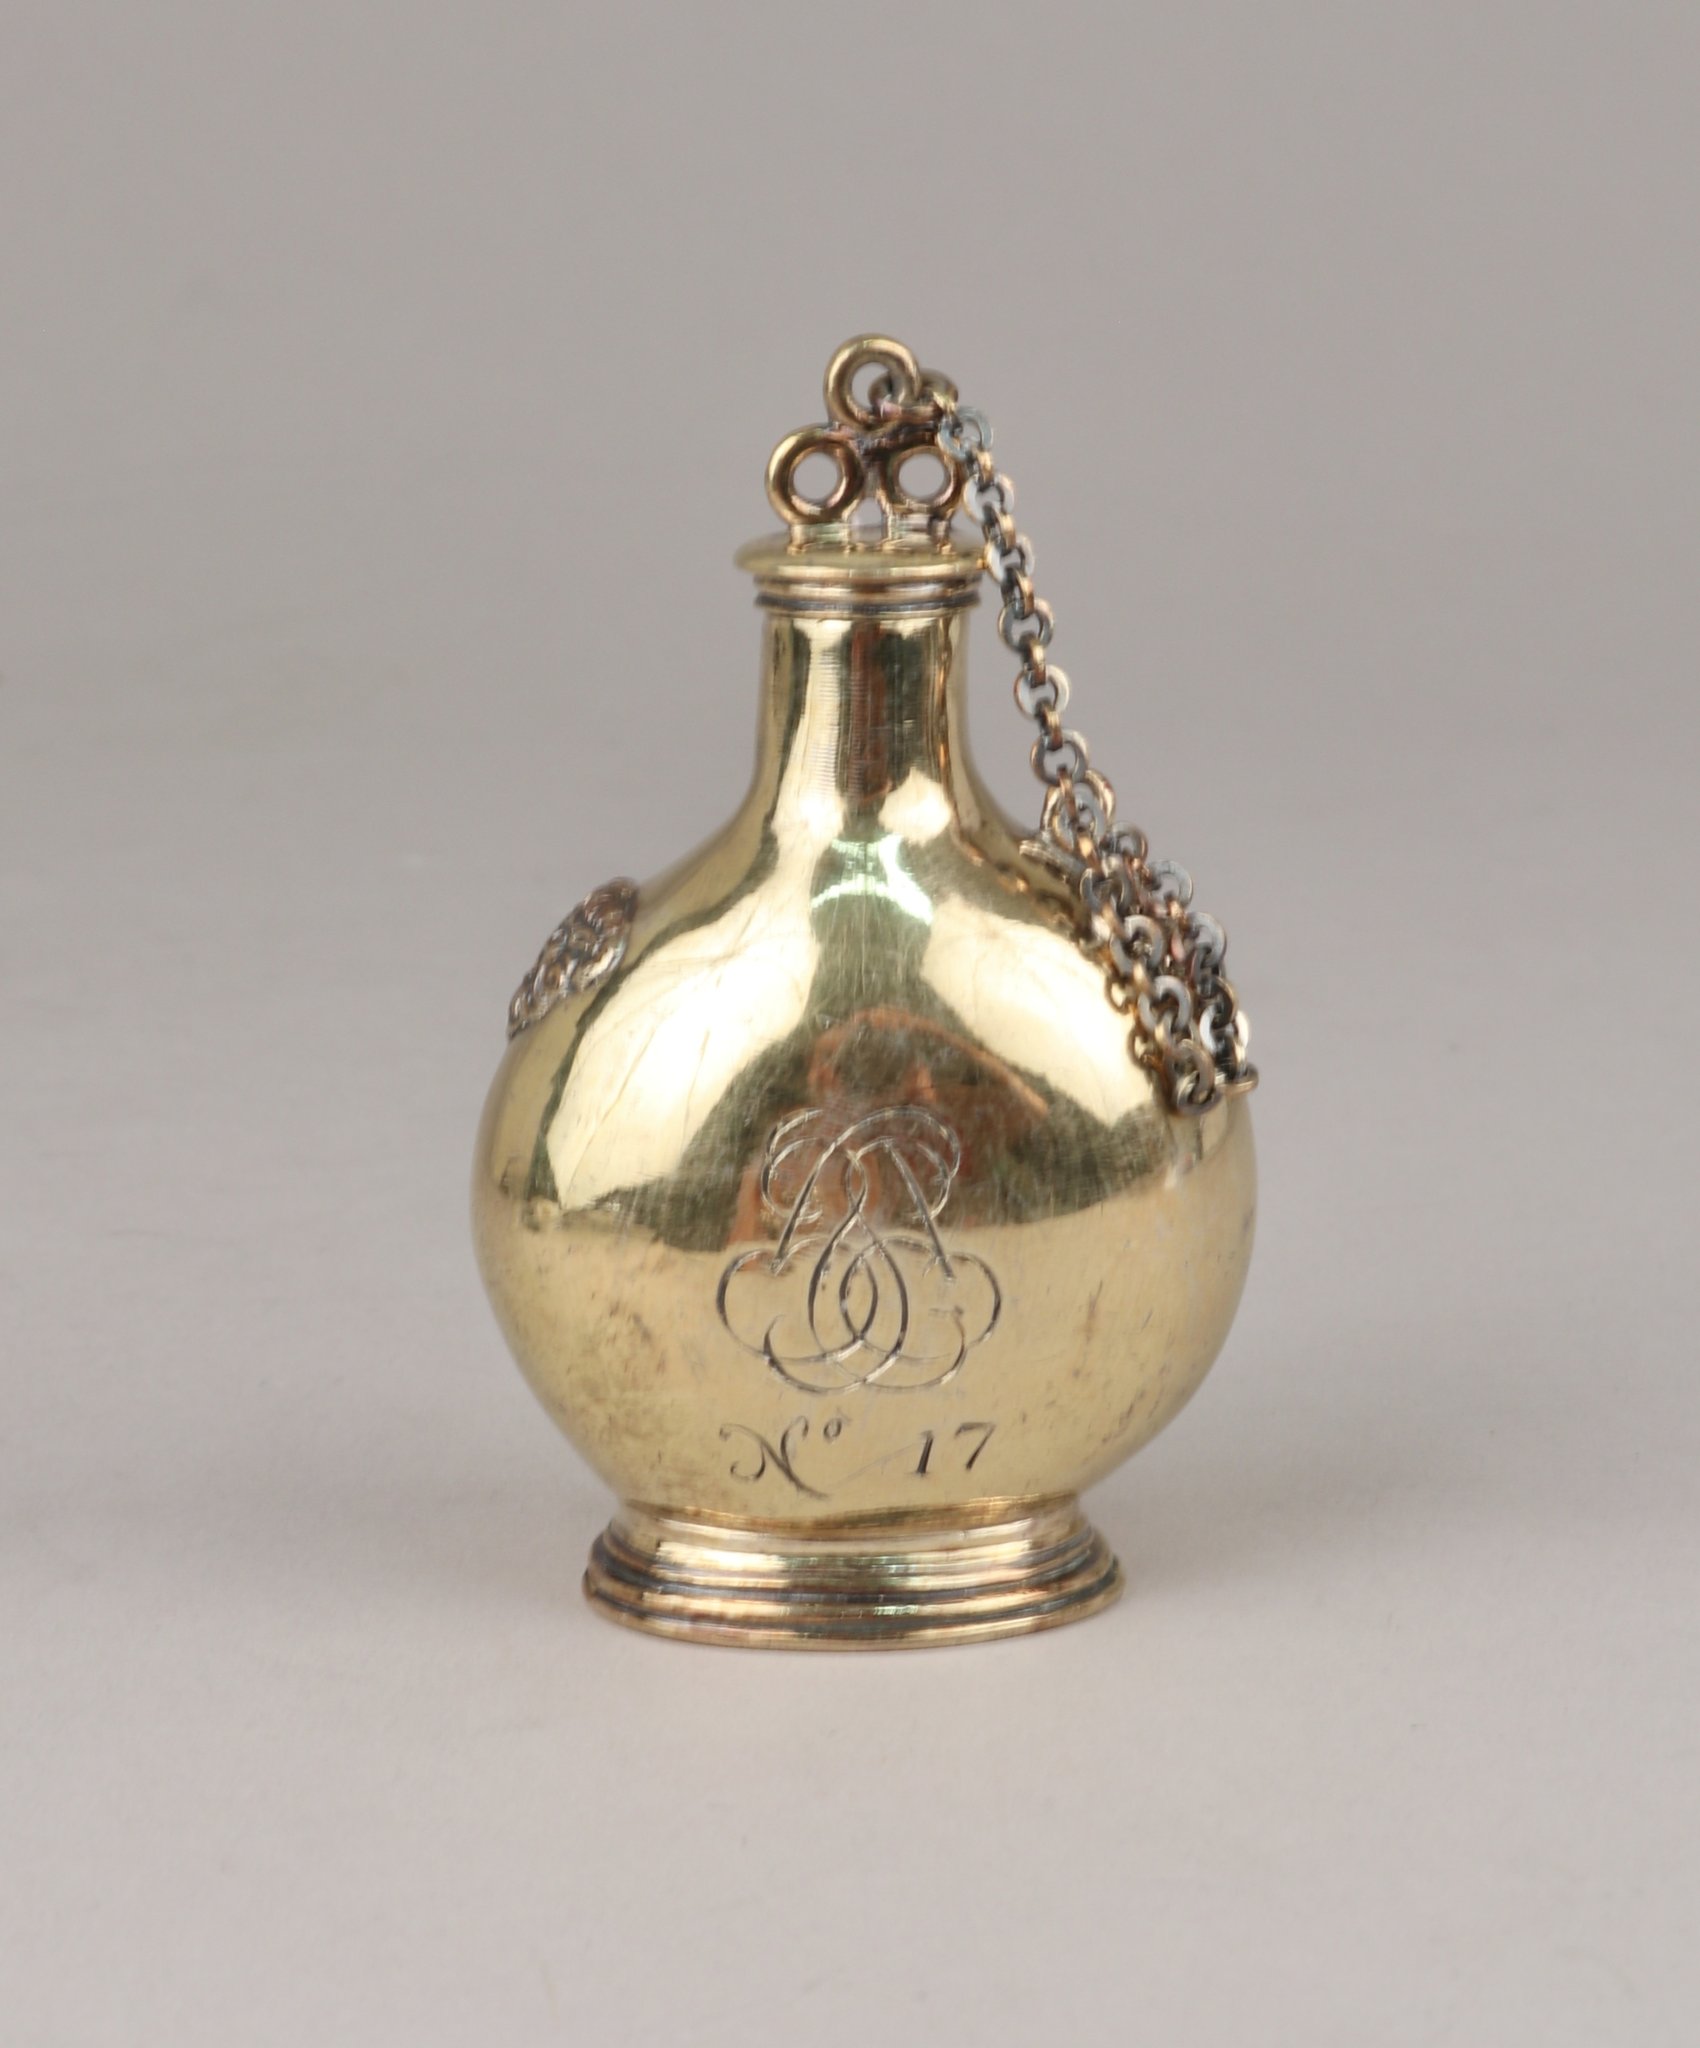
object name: bottle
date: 1801-1900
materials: metal, silver